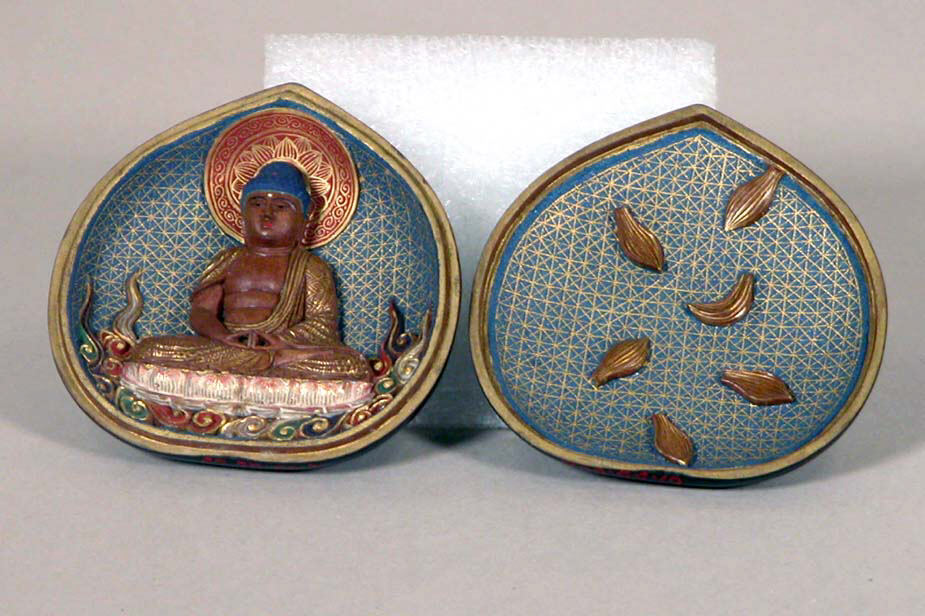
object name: traveller's shrine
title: Traveller's Shrine with Figure of Amida Buddha Seated on Lotus Throne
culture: japanese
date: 1867-1900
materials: gilt, lacquer, paint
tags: buddhism,buddha